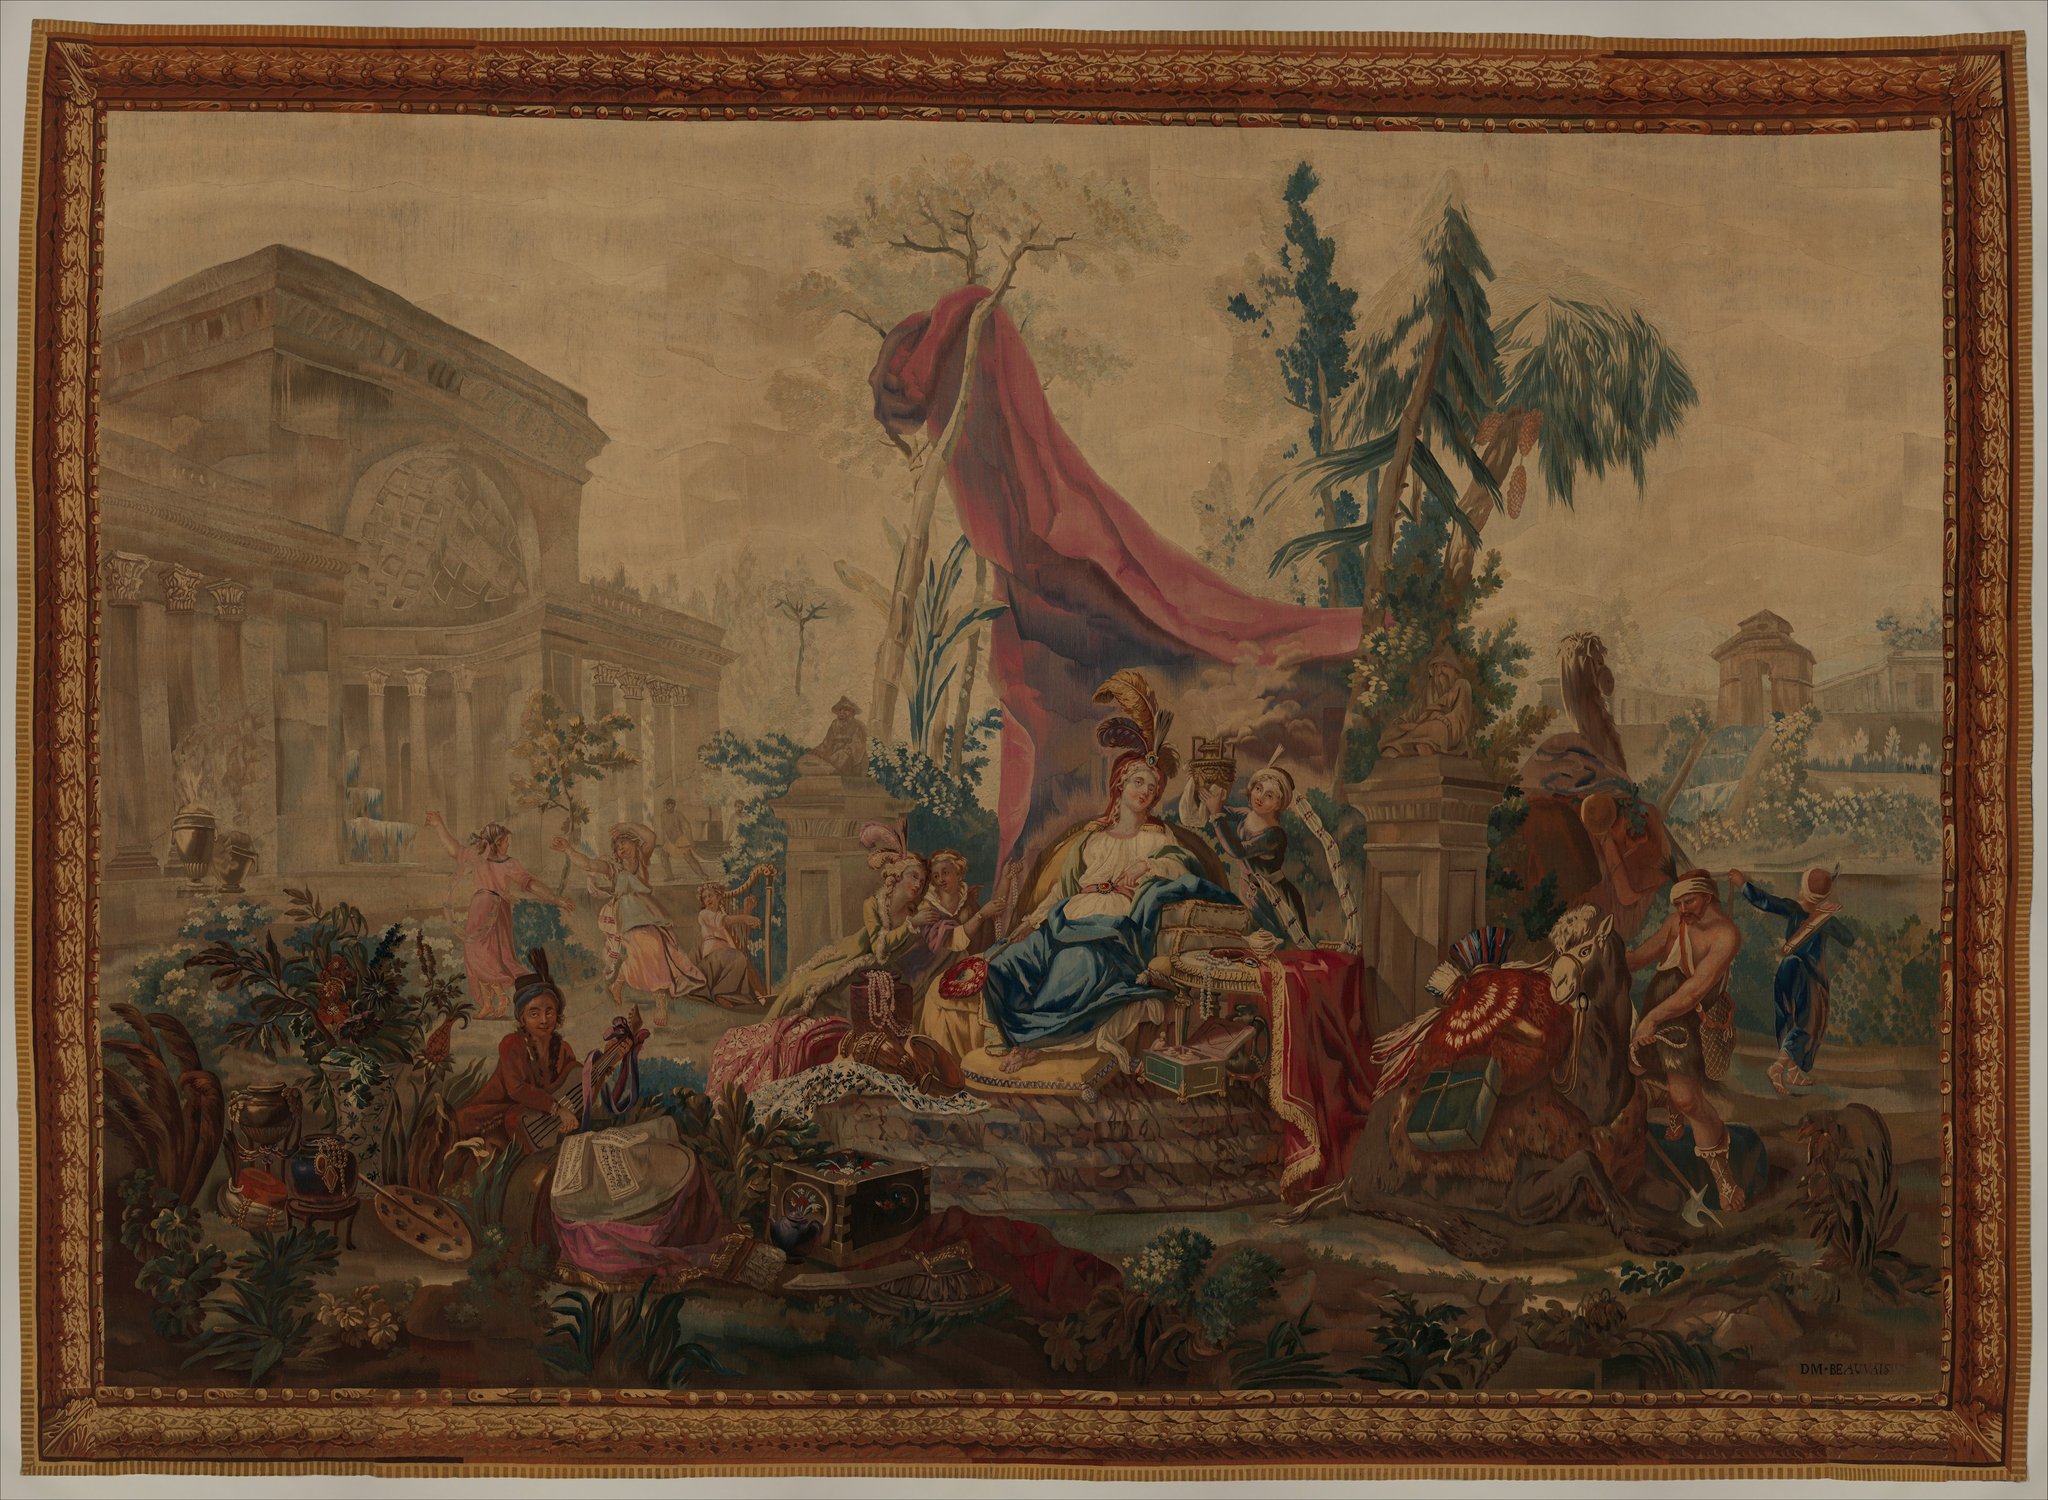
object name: tapestry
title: Asia from a set of The Four Continents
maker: jean jacques françois le barbier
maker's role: designer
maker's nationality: french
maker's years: 1738-1826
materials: silk, wool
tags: men,women,guitars,harps,camels